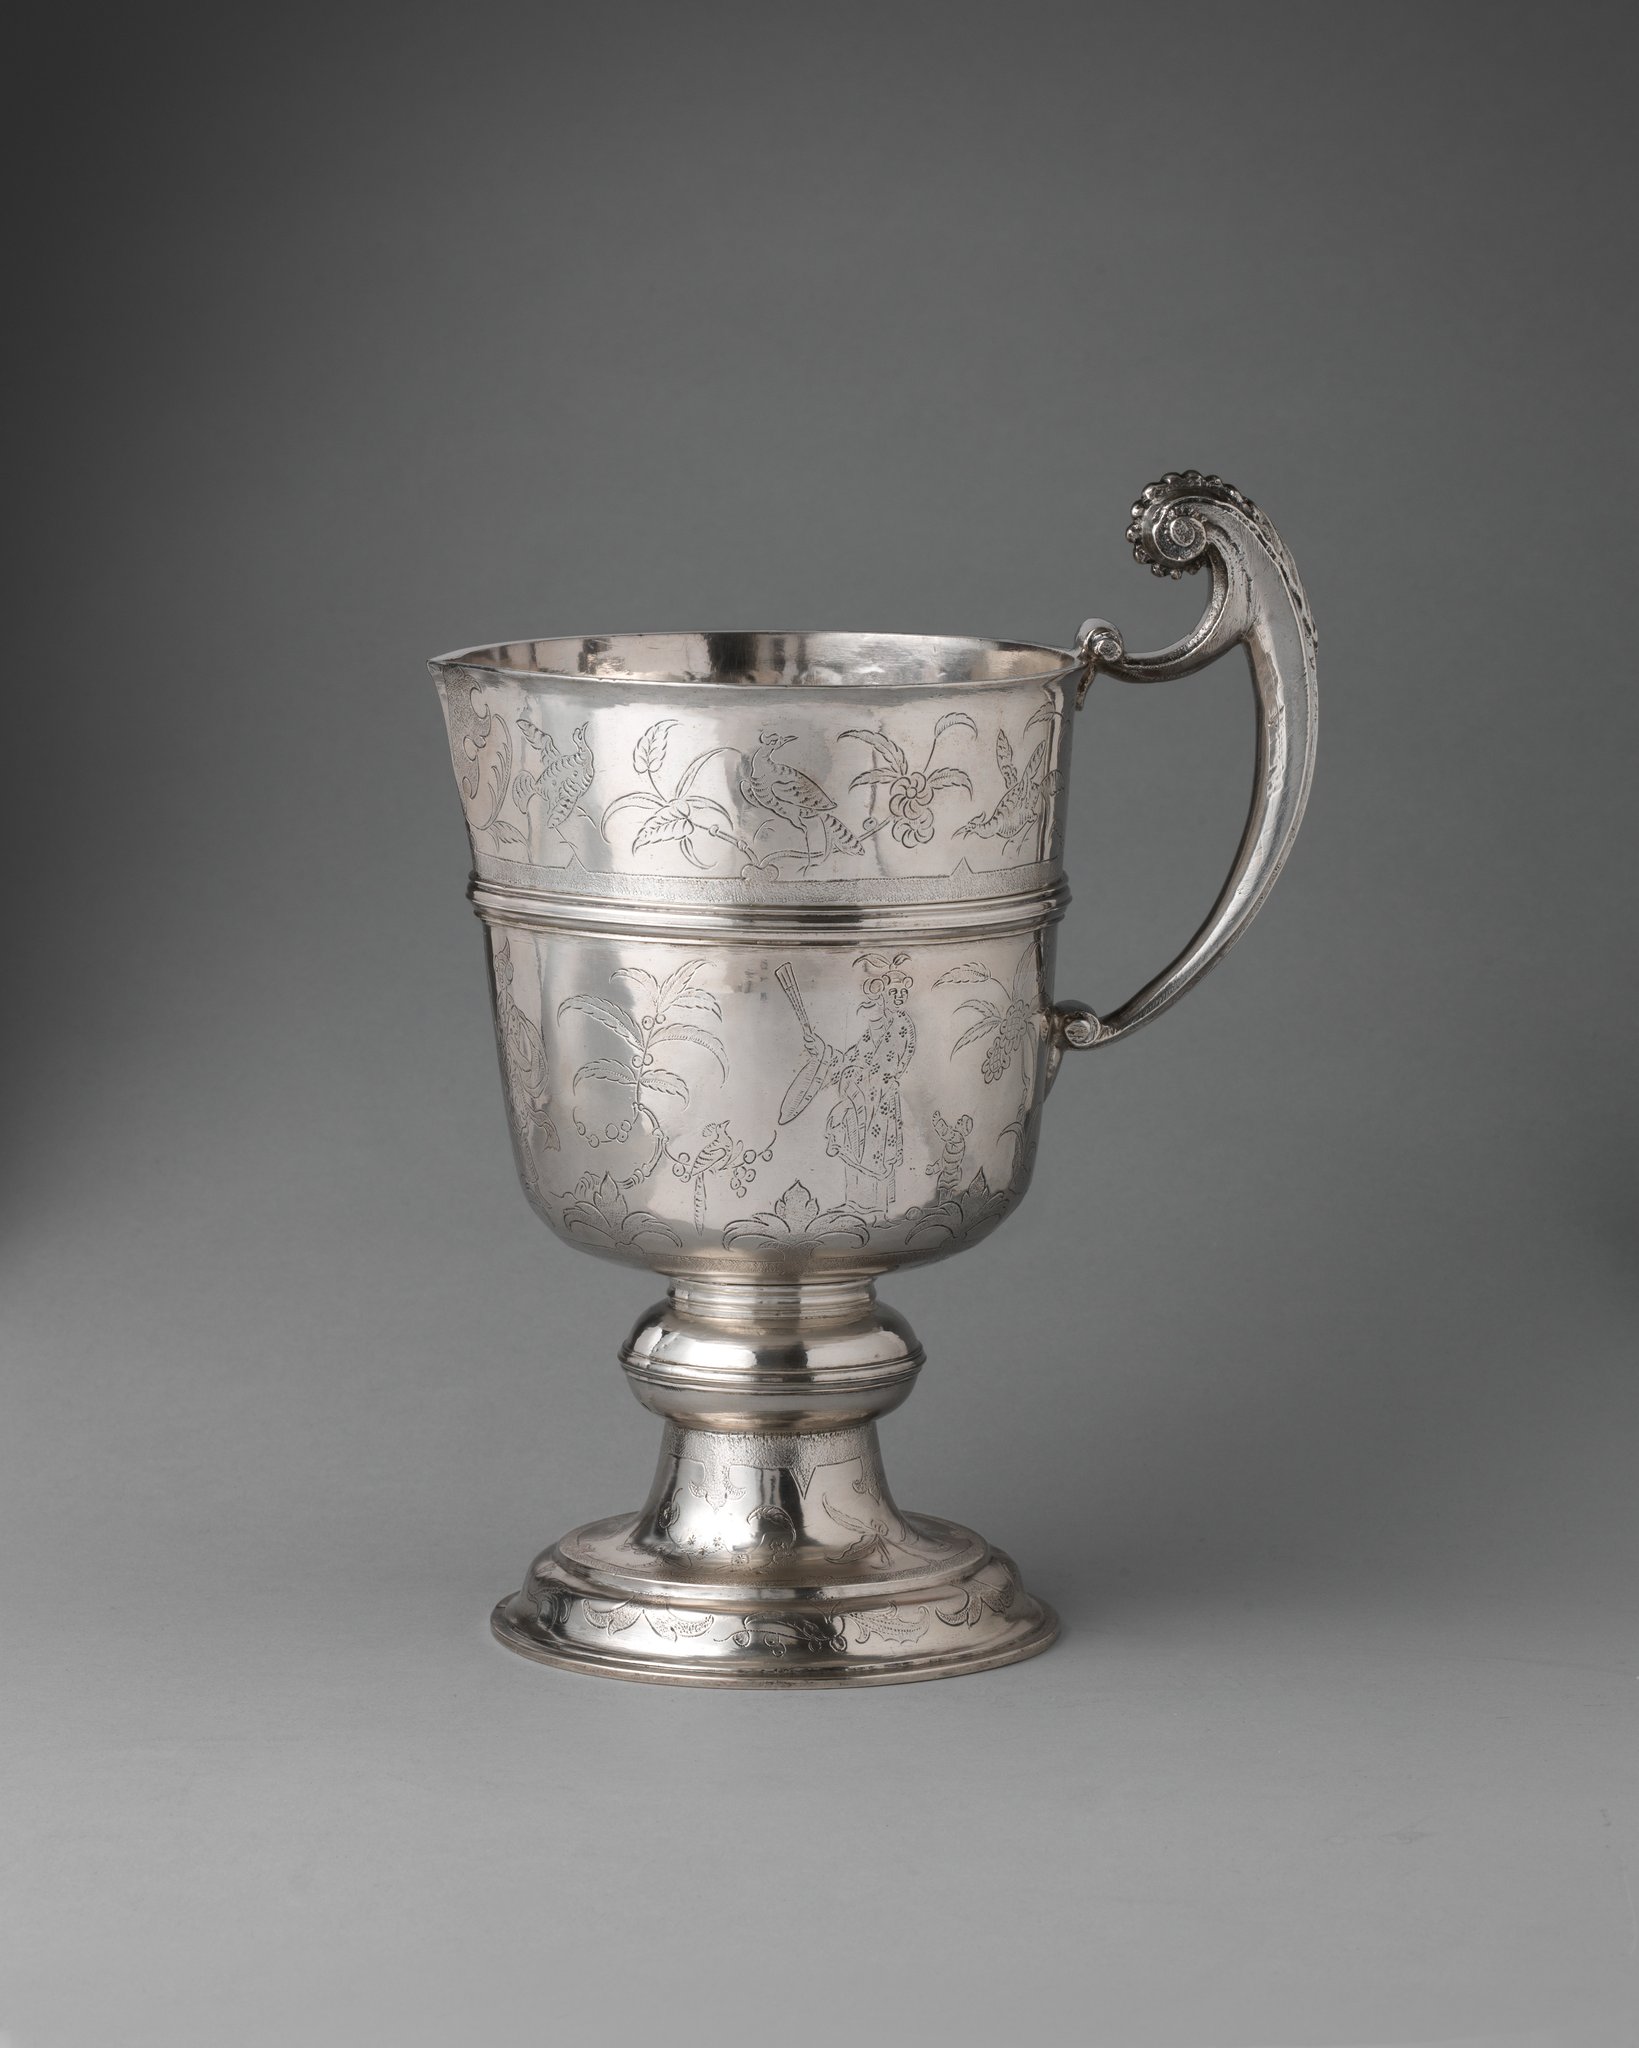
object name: ewer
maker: p. k., london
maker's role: maker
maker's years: 1683-1686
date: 1685-1686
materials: silver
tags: birds,men